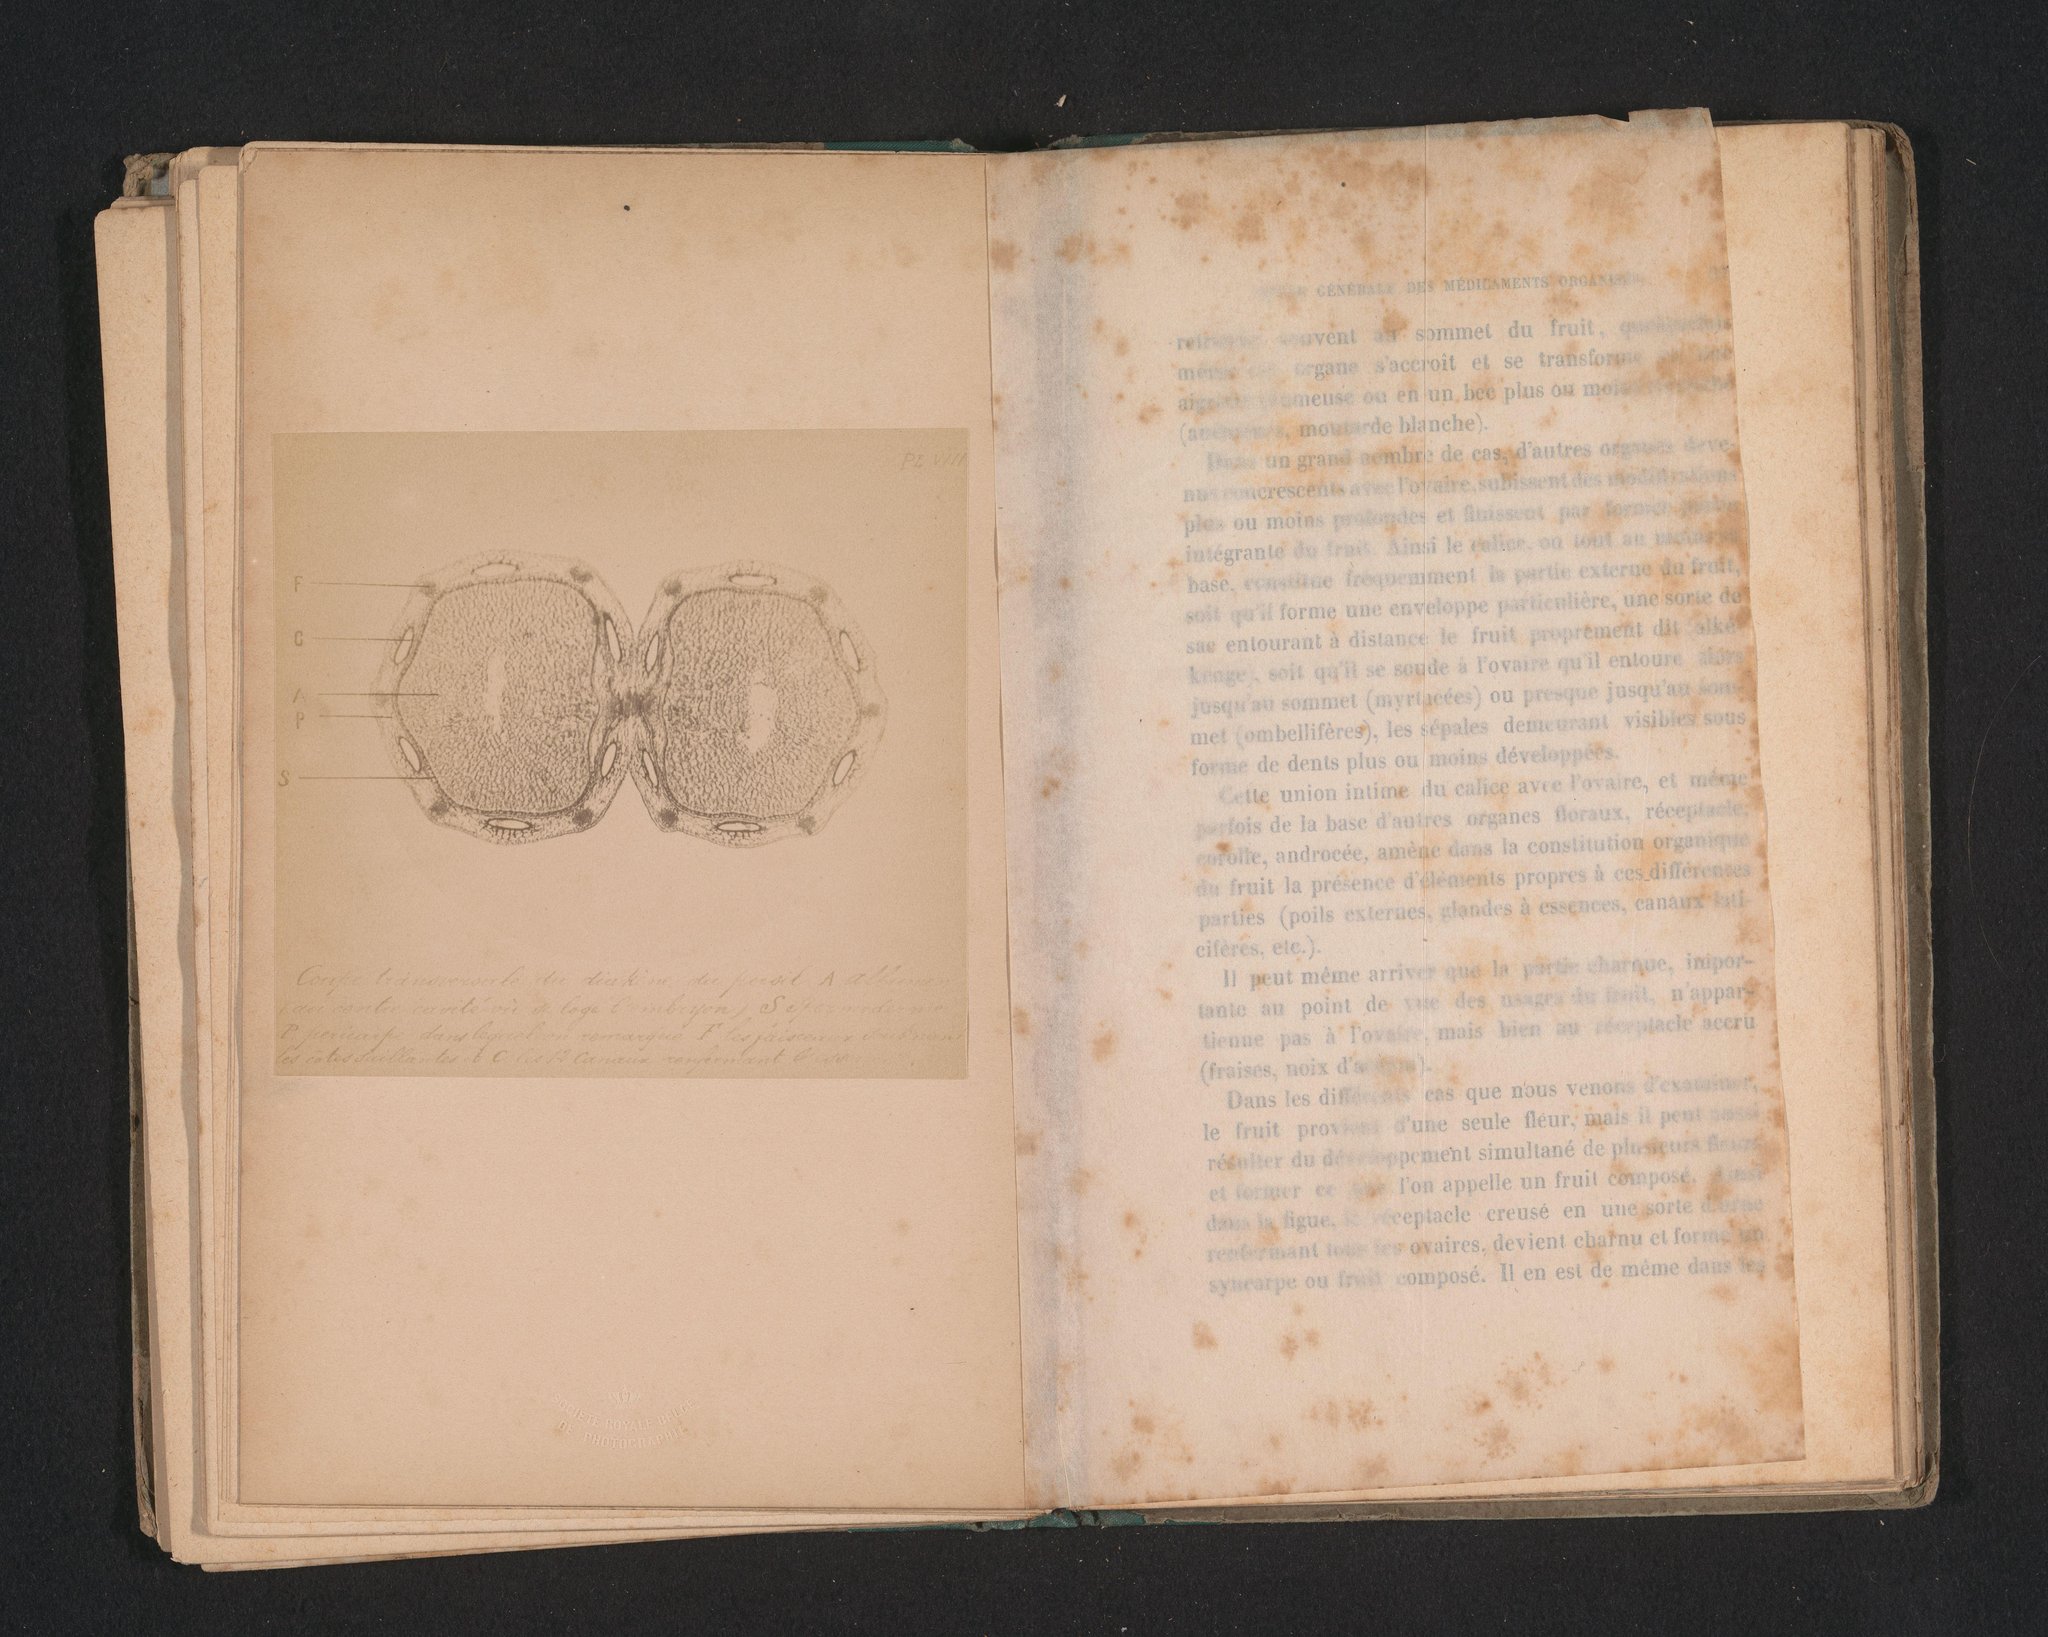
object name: photograph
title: Dwarsdoorsnede van een onbekend onderdeel van een plant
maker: Anonymous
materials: photographic support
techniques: albumen print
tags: plants; vegetation